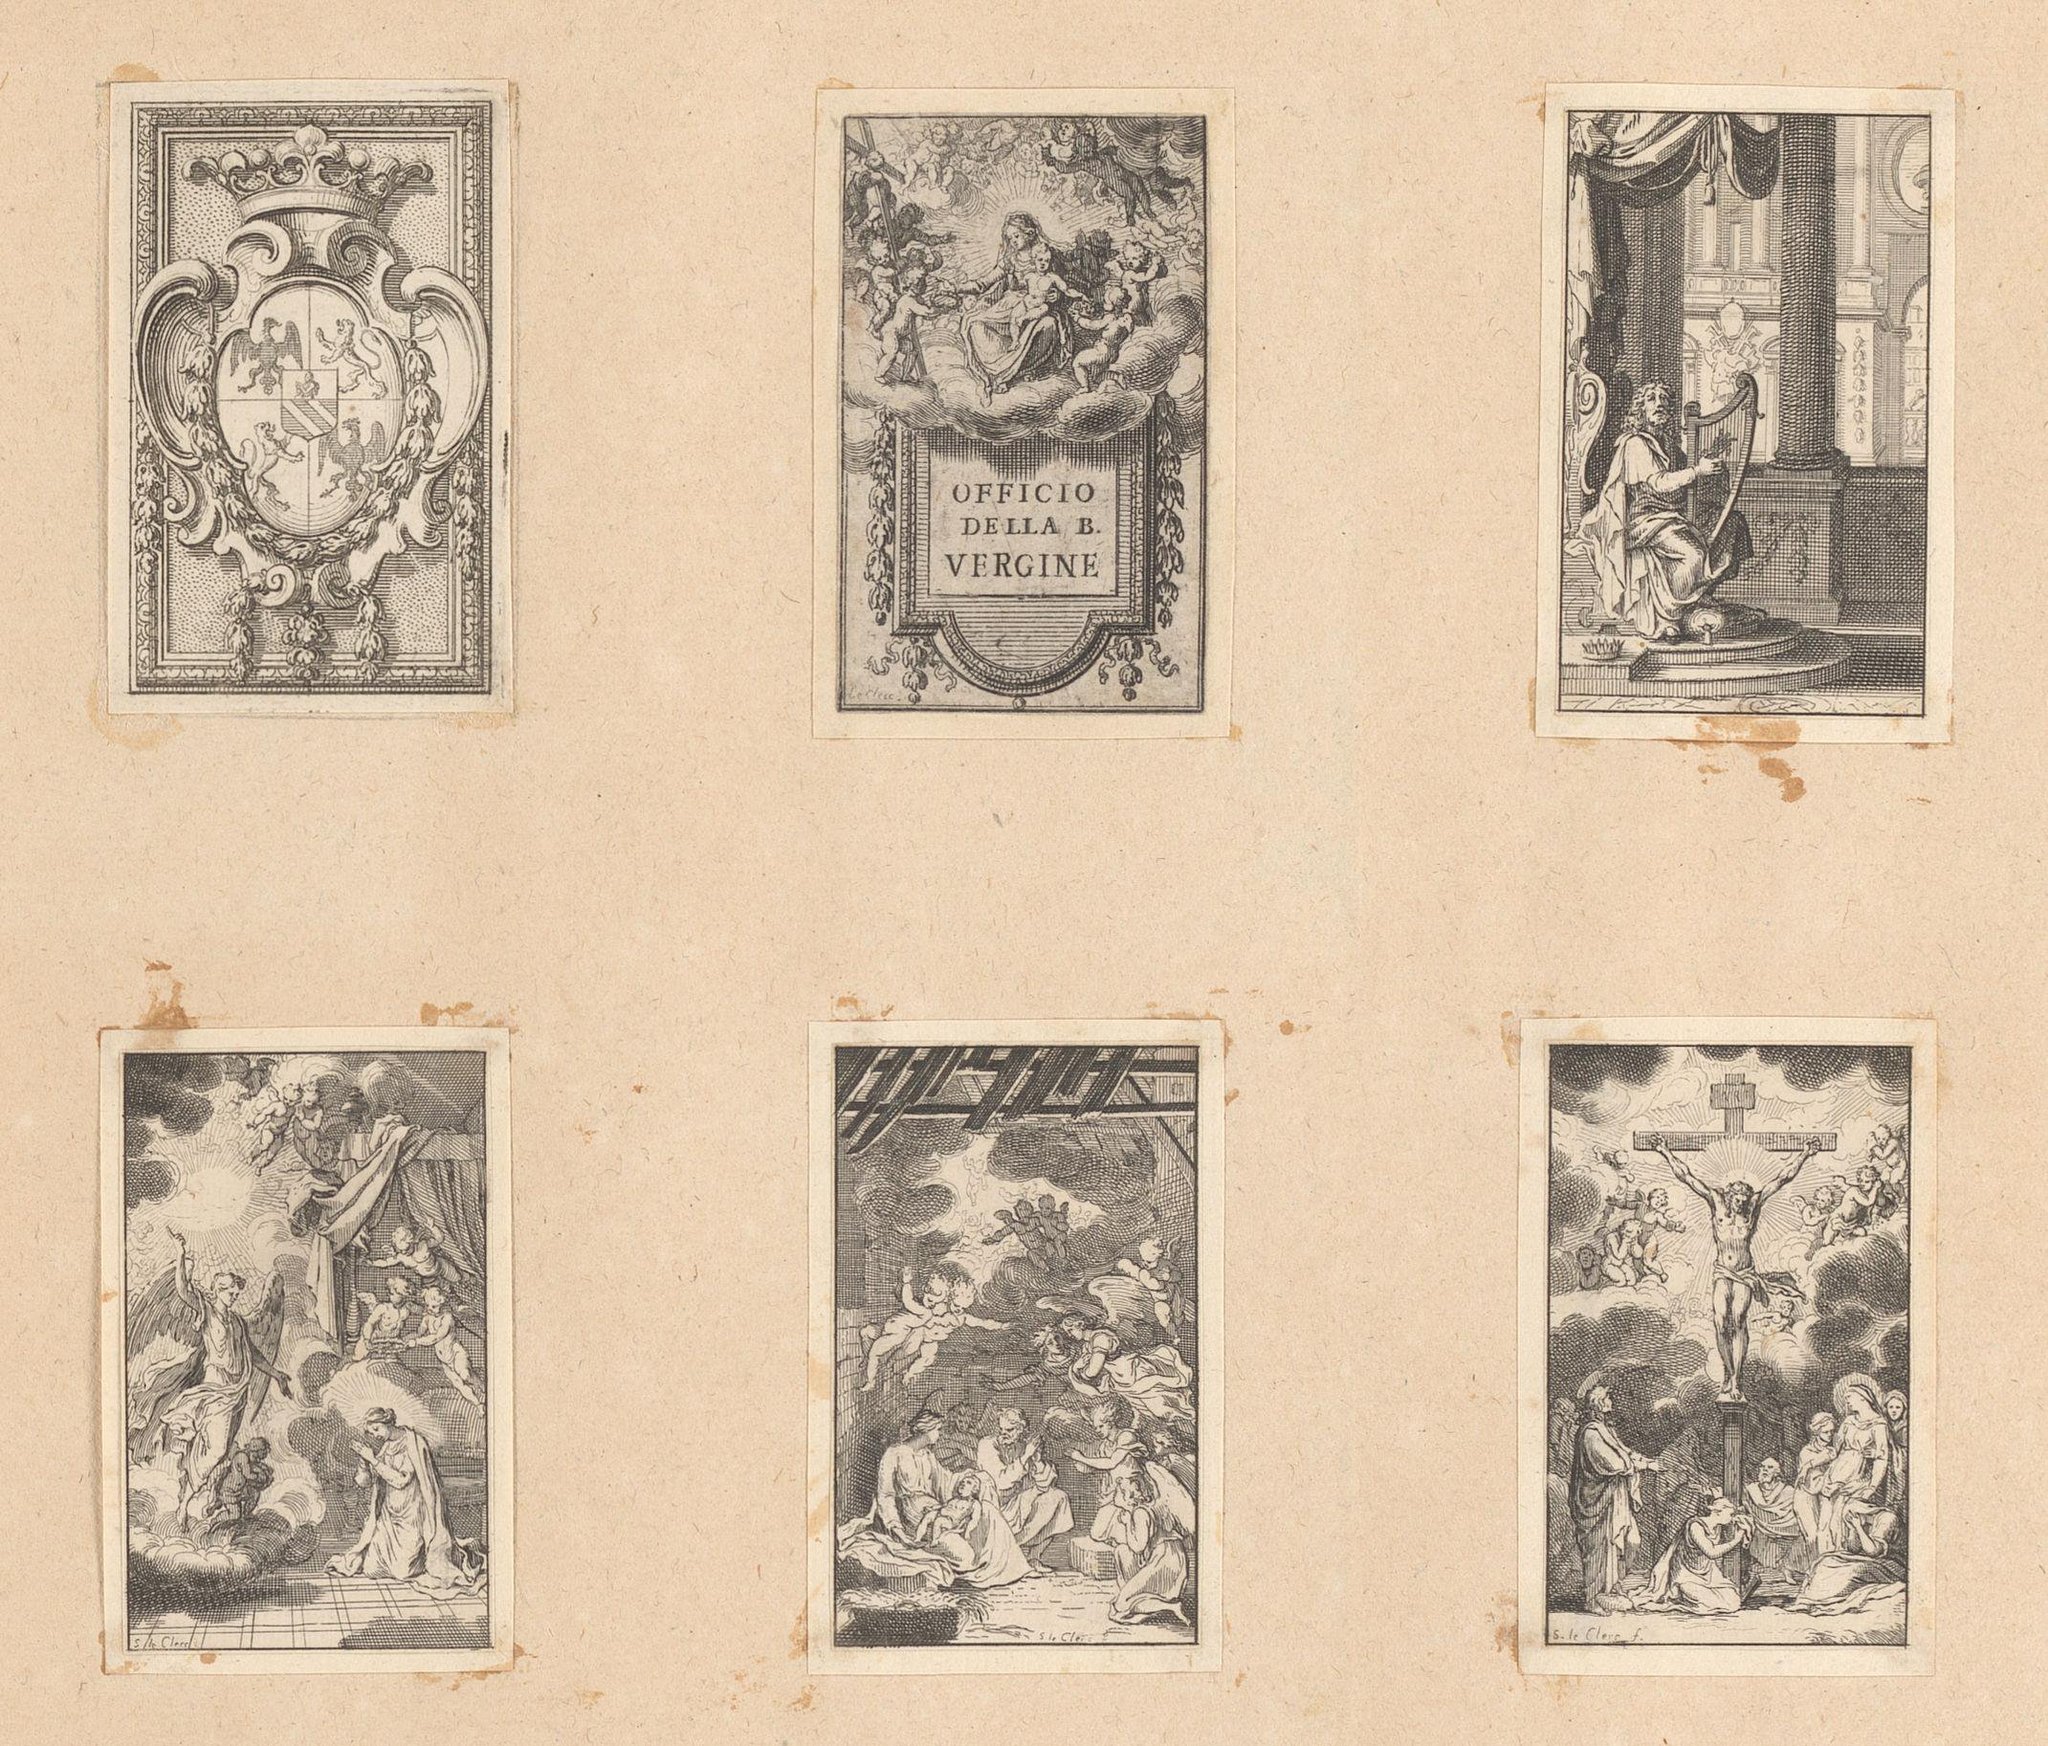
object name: print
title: Officio della B. Vergine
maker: sébastien leclerc (i)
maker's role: print maker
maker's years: 1637-1714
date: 1647-1680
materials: paper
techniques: etching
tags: the annunciation: mary kneeling, adoration of the christ-child ~ christ's birth, story of david, the crucifixion of christ: christ's death on the cross; golgotha (matthew 27:45-58; mark 15:33-45; luke 23:44-52; john 19:25-38)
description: Deze prenten maken deel uit van een zesdelige serie getiteld 'Officio della B. Vergine', maar ook wel bekend als 'les Petites heures de Venise'. De eerste prent betreft een wapenschild, de tweede de titelprent, de derde een voorstelling van Koning David, de derde de Annunciatie, de vierde de Aanbidding der engelen en de vierde de Kruisiging.